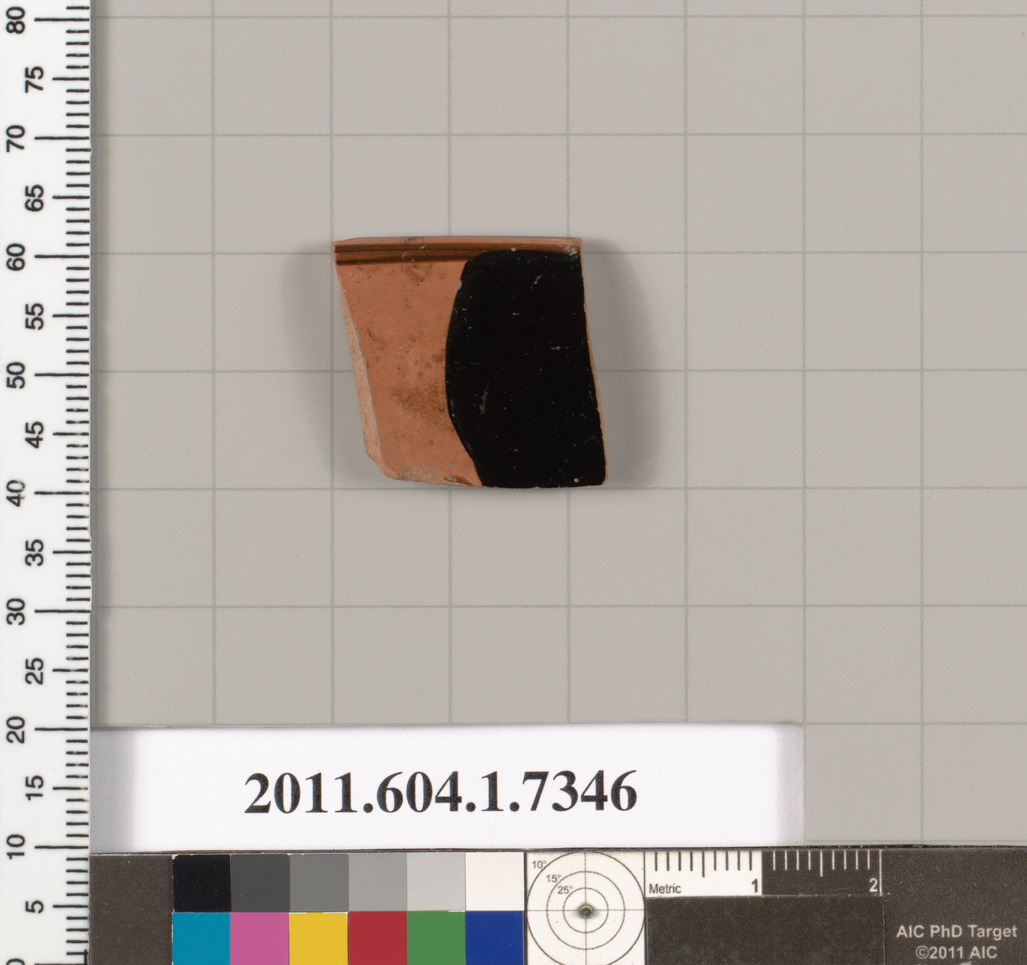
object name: kylix fragment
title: Terracotta rim fragment of a kylix (drinking cup)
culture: greek, attic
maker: makron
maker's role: artist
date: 500-480 BCE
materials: terracotta